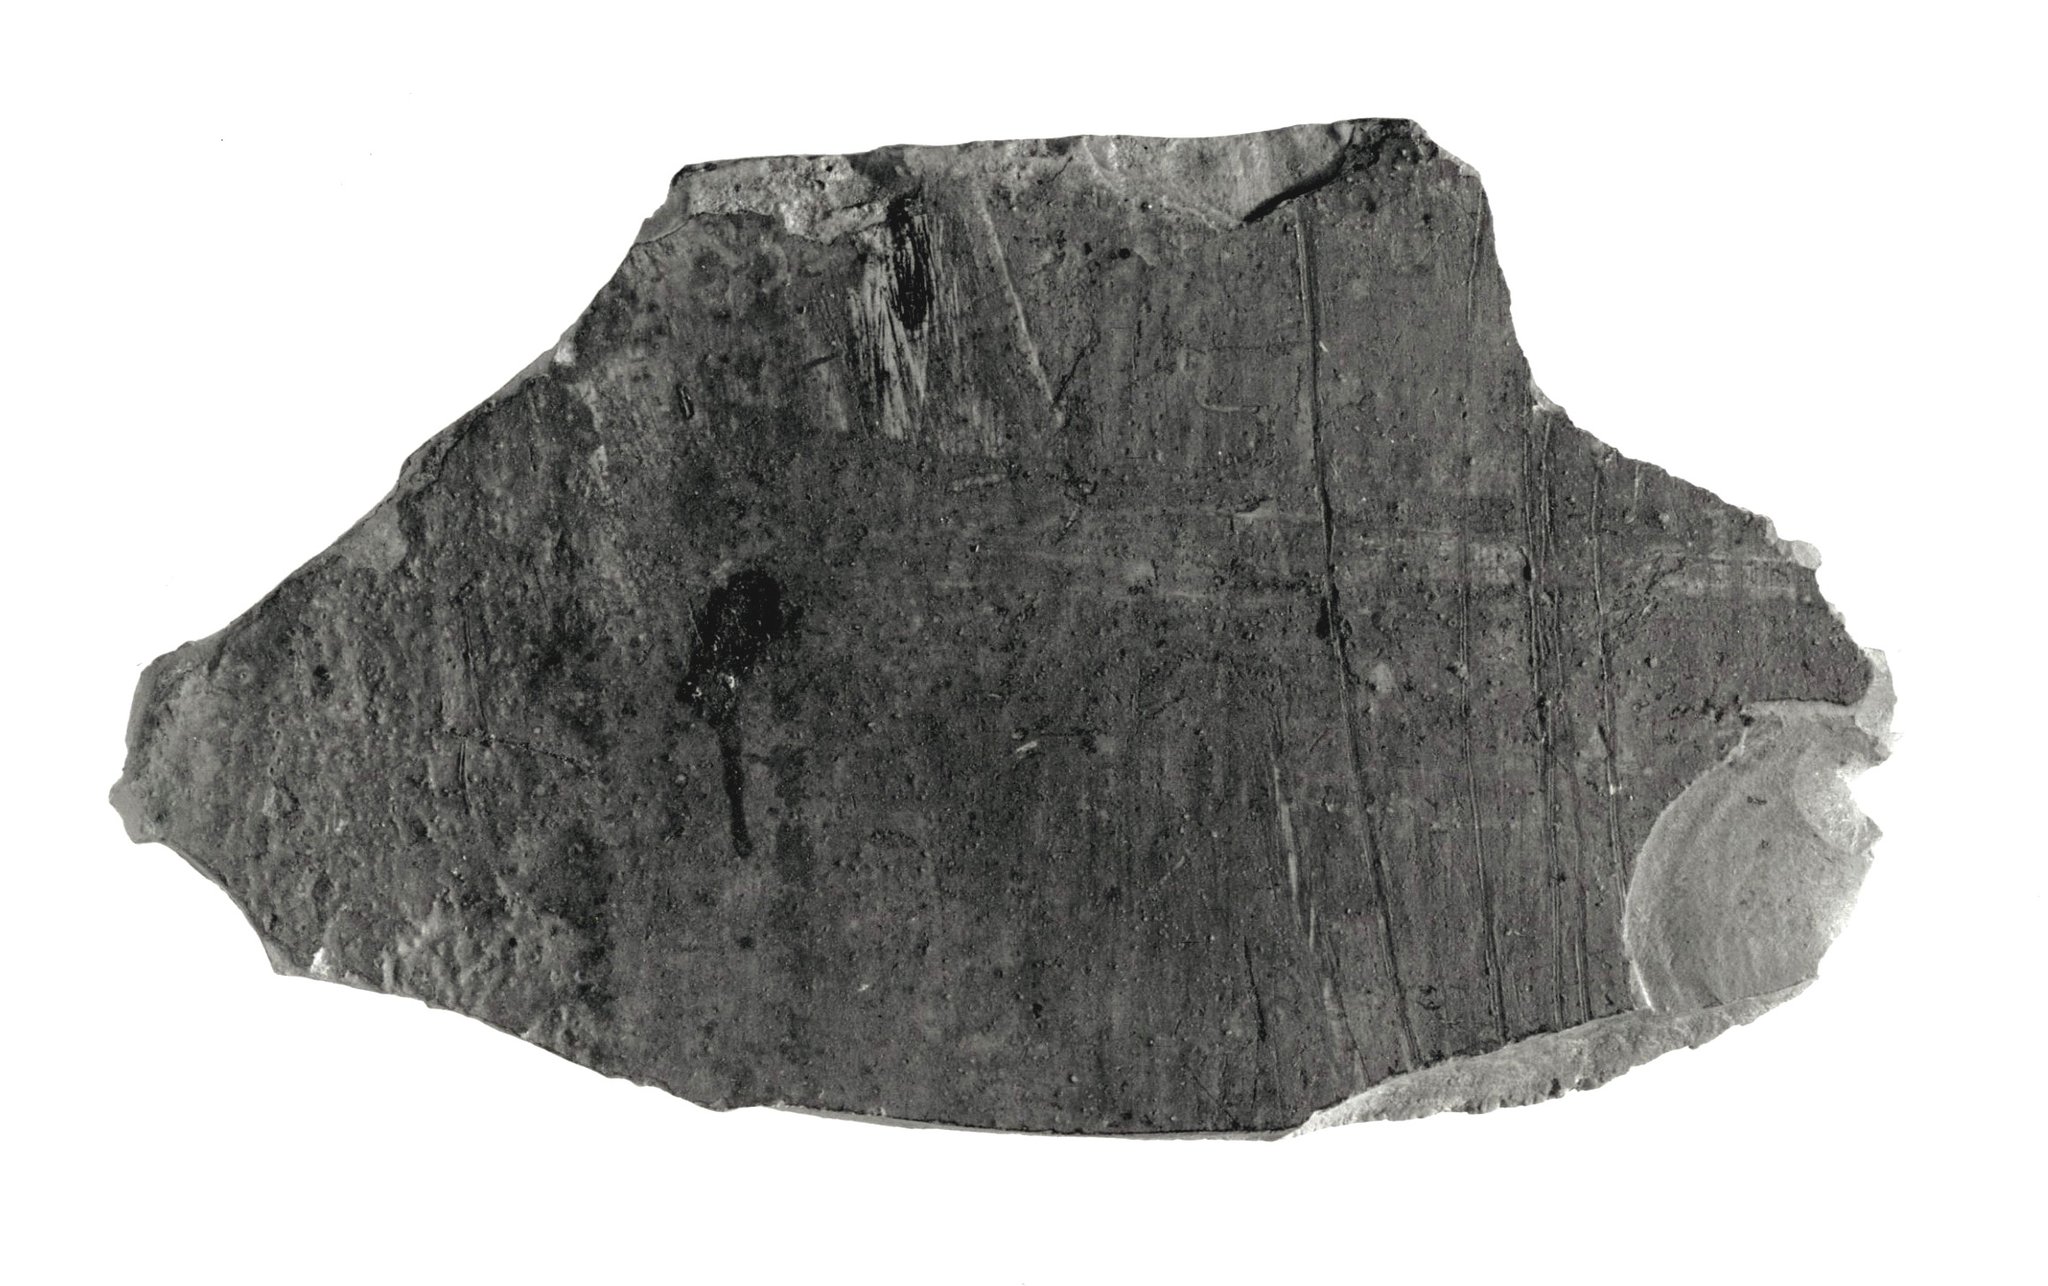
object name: relief, tomb of nespekashuty, wall casing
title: Wall casing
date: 664-610 BCE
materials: limestone, varnish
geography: egypt